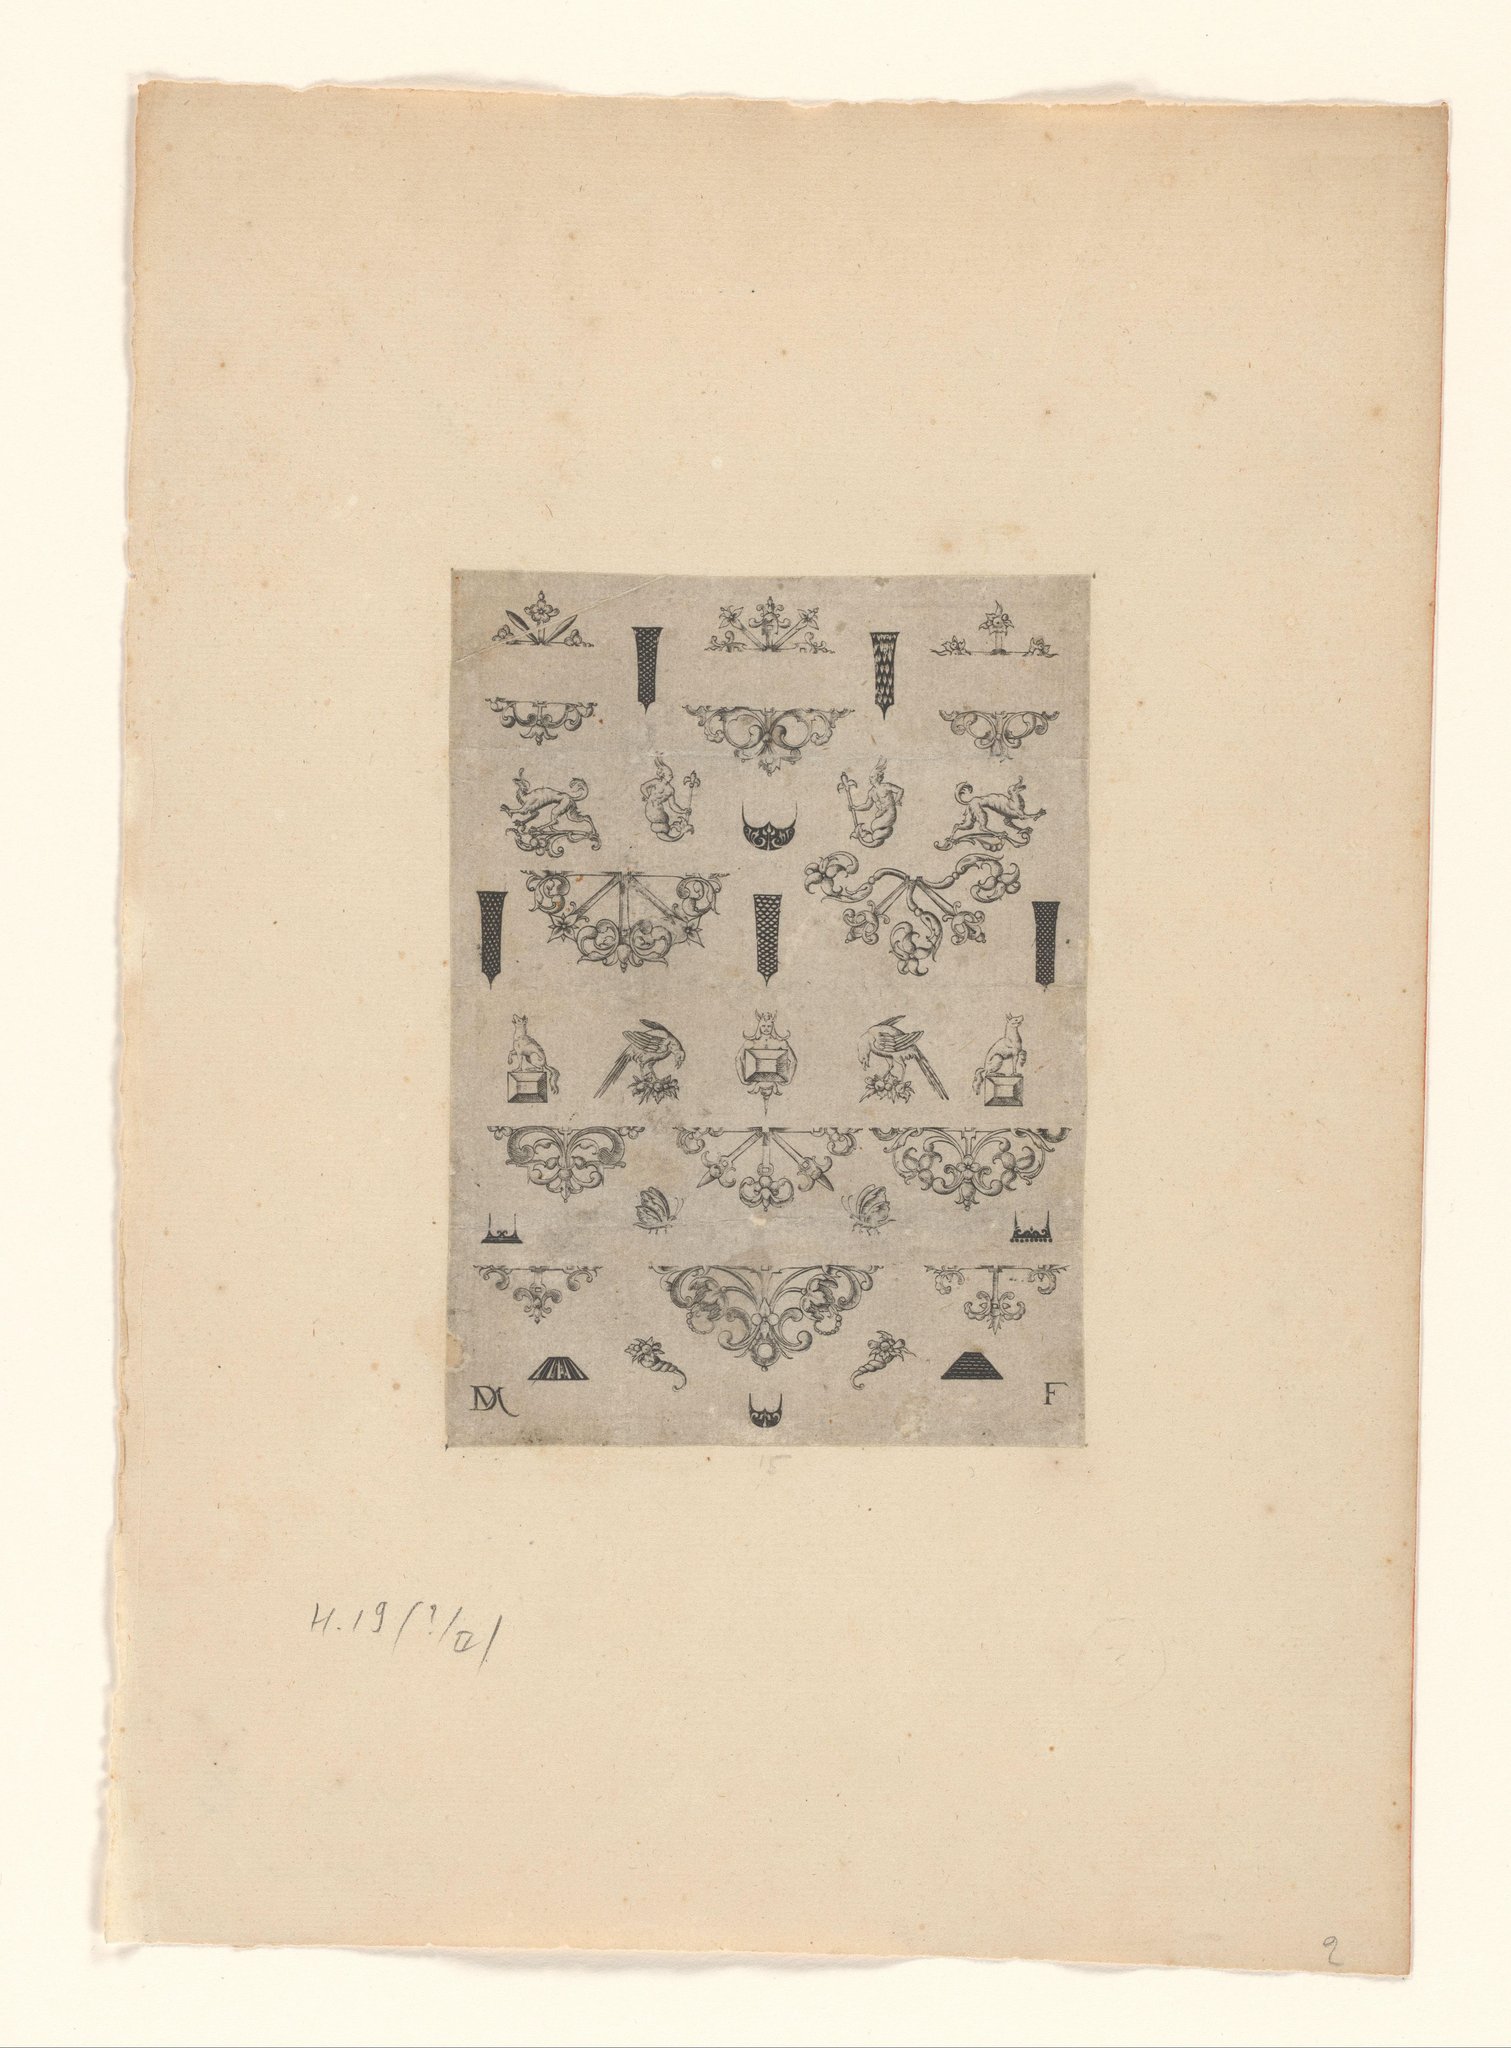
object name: ornament print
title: Ornamentprent met ontwerp voor edelsmeedkunst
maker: daniel mignot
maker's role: print maker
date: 1593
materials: paper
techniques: engraving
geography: augsburg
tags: ornaments ~ art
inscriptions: collector's mark: Lugt 2228, collector's mark: Lugt 2760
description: Verschillende kleine zwartwerk- en andere ornamenten.